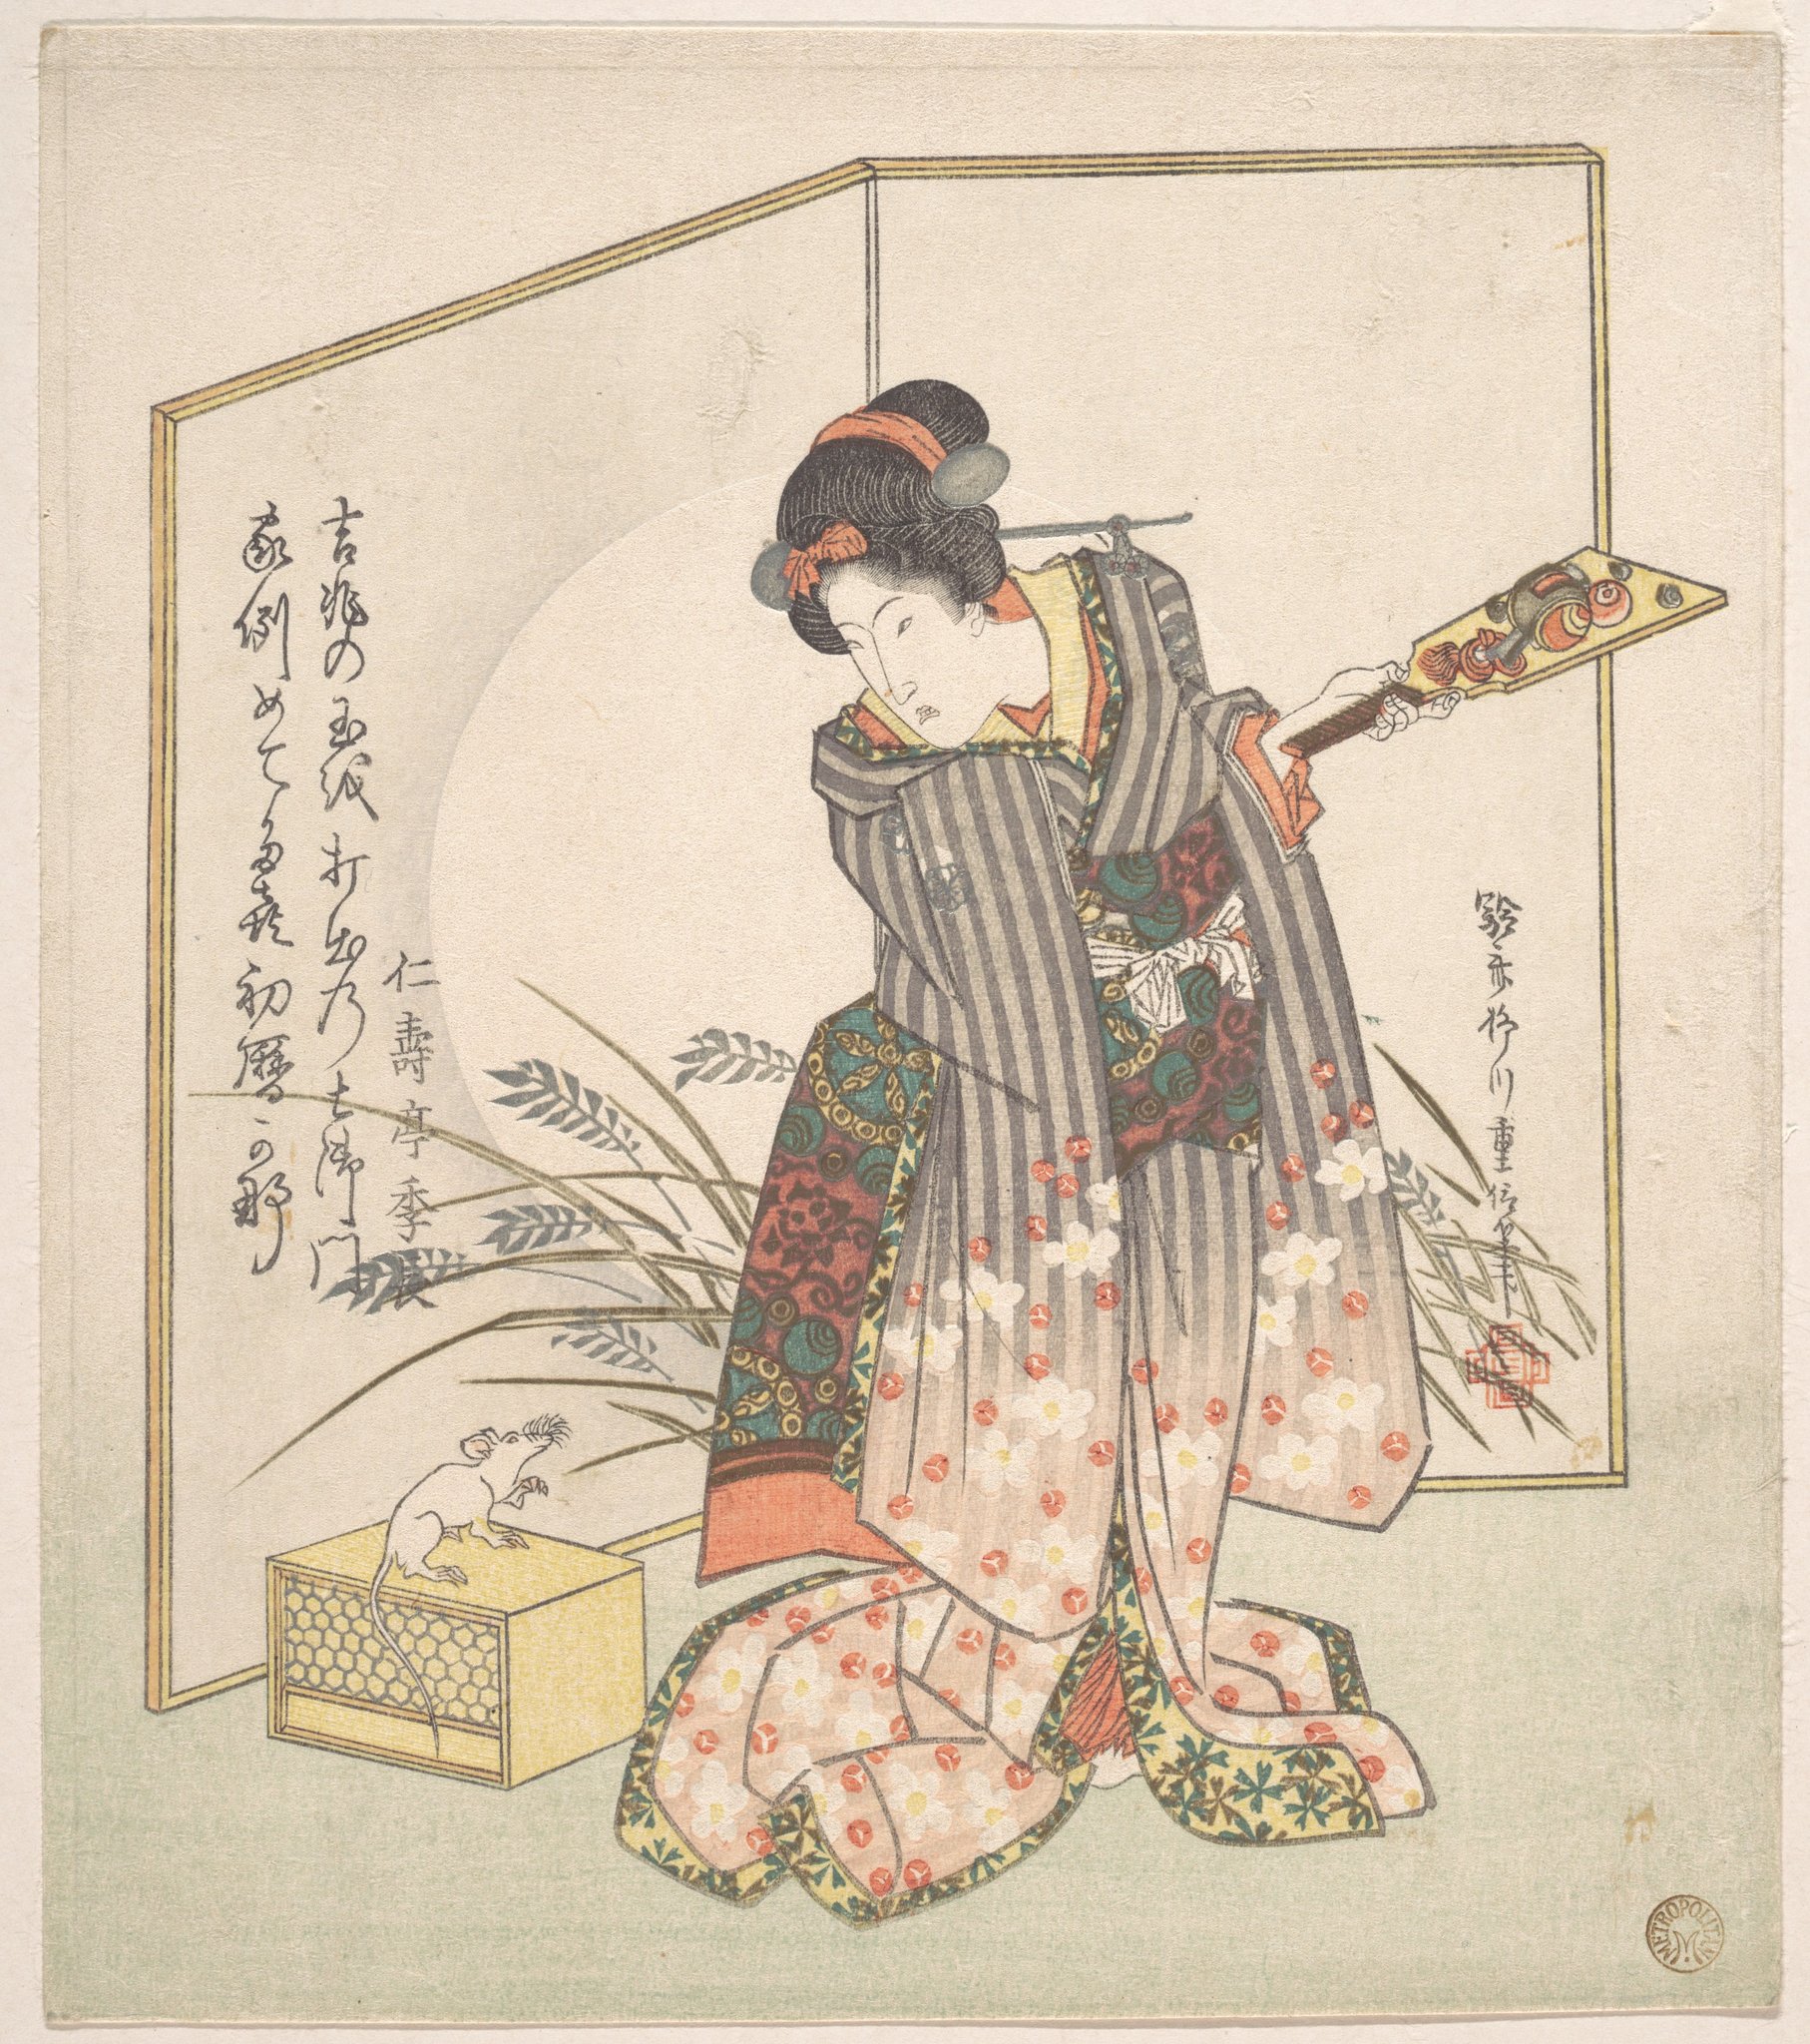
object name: print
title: New Year Greeting Card for "Rat" Year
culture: japanese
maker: yanagawa shigenobu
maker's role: artist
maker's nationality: japanese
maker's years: 1787-1832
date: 1828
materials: ink, paper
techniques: surimono, woodblock print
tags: women,rats